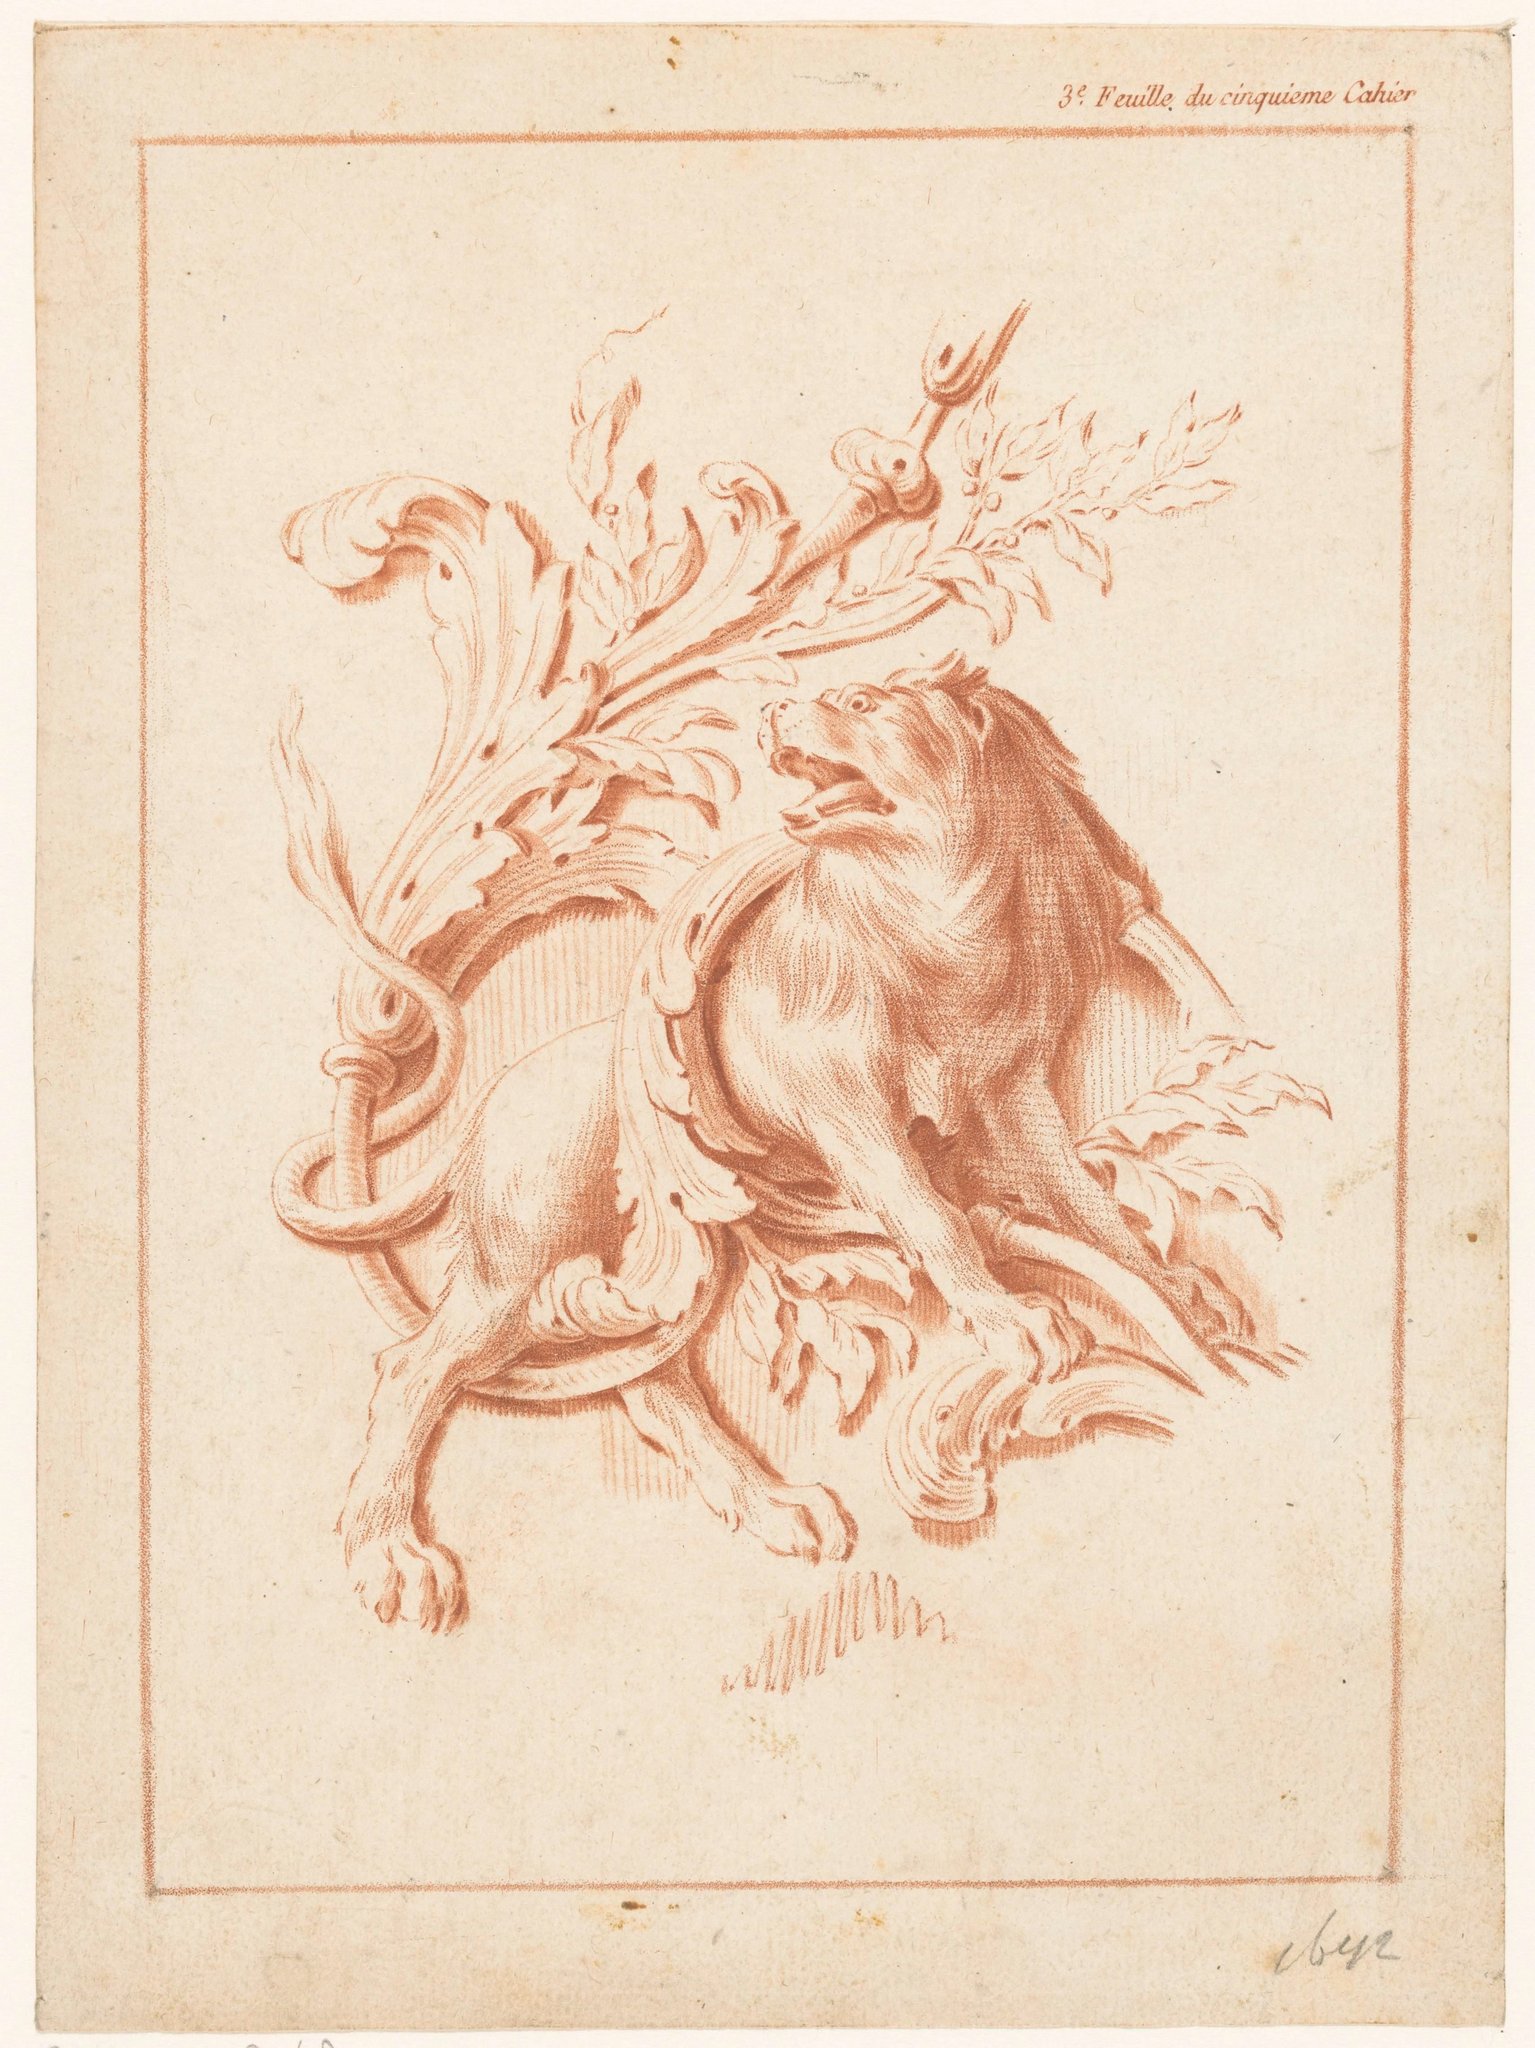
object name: ornament print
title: Leeuw met ranken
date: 1770-1780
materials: paper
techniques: printmaking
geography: paris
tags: beasts of prey, predatory animals: lion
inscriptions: collector's mark: Lugt 2228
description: Een brullende leeuw, omstrengeld door een bladrank.